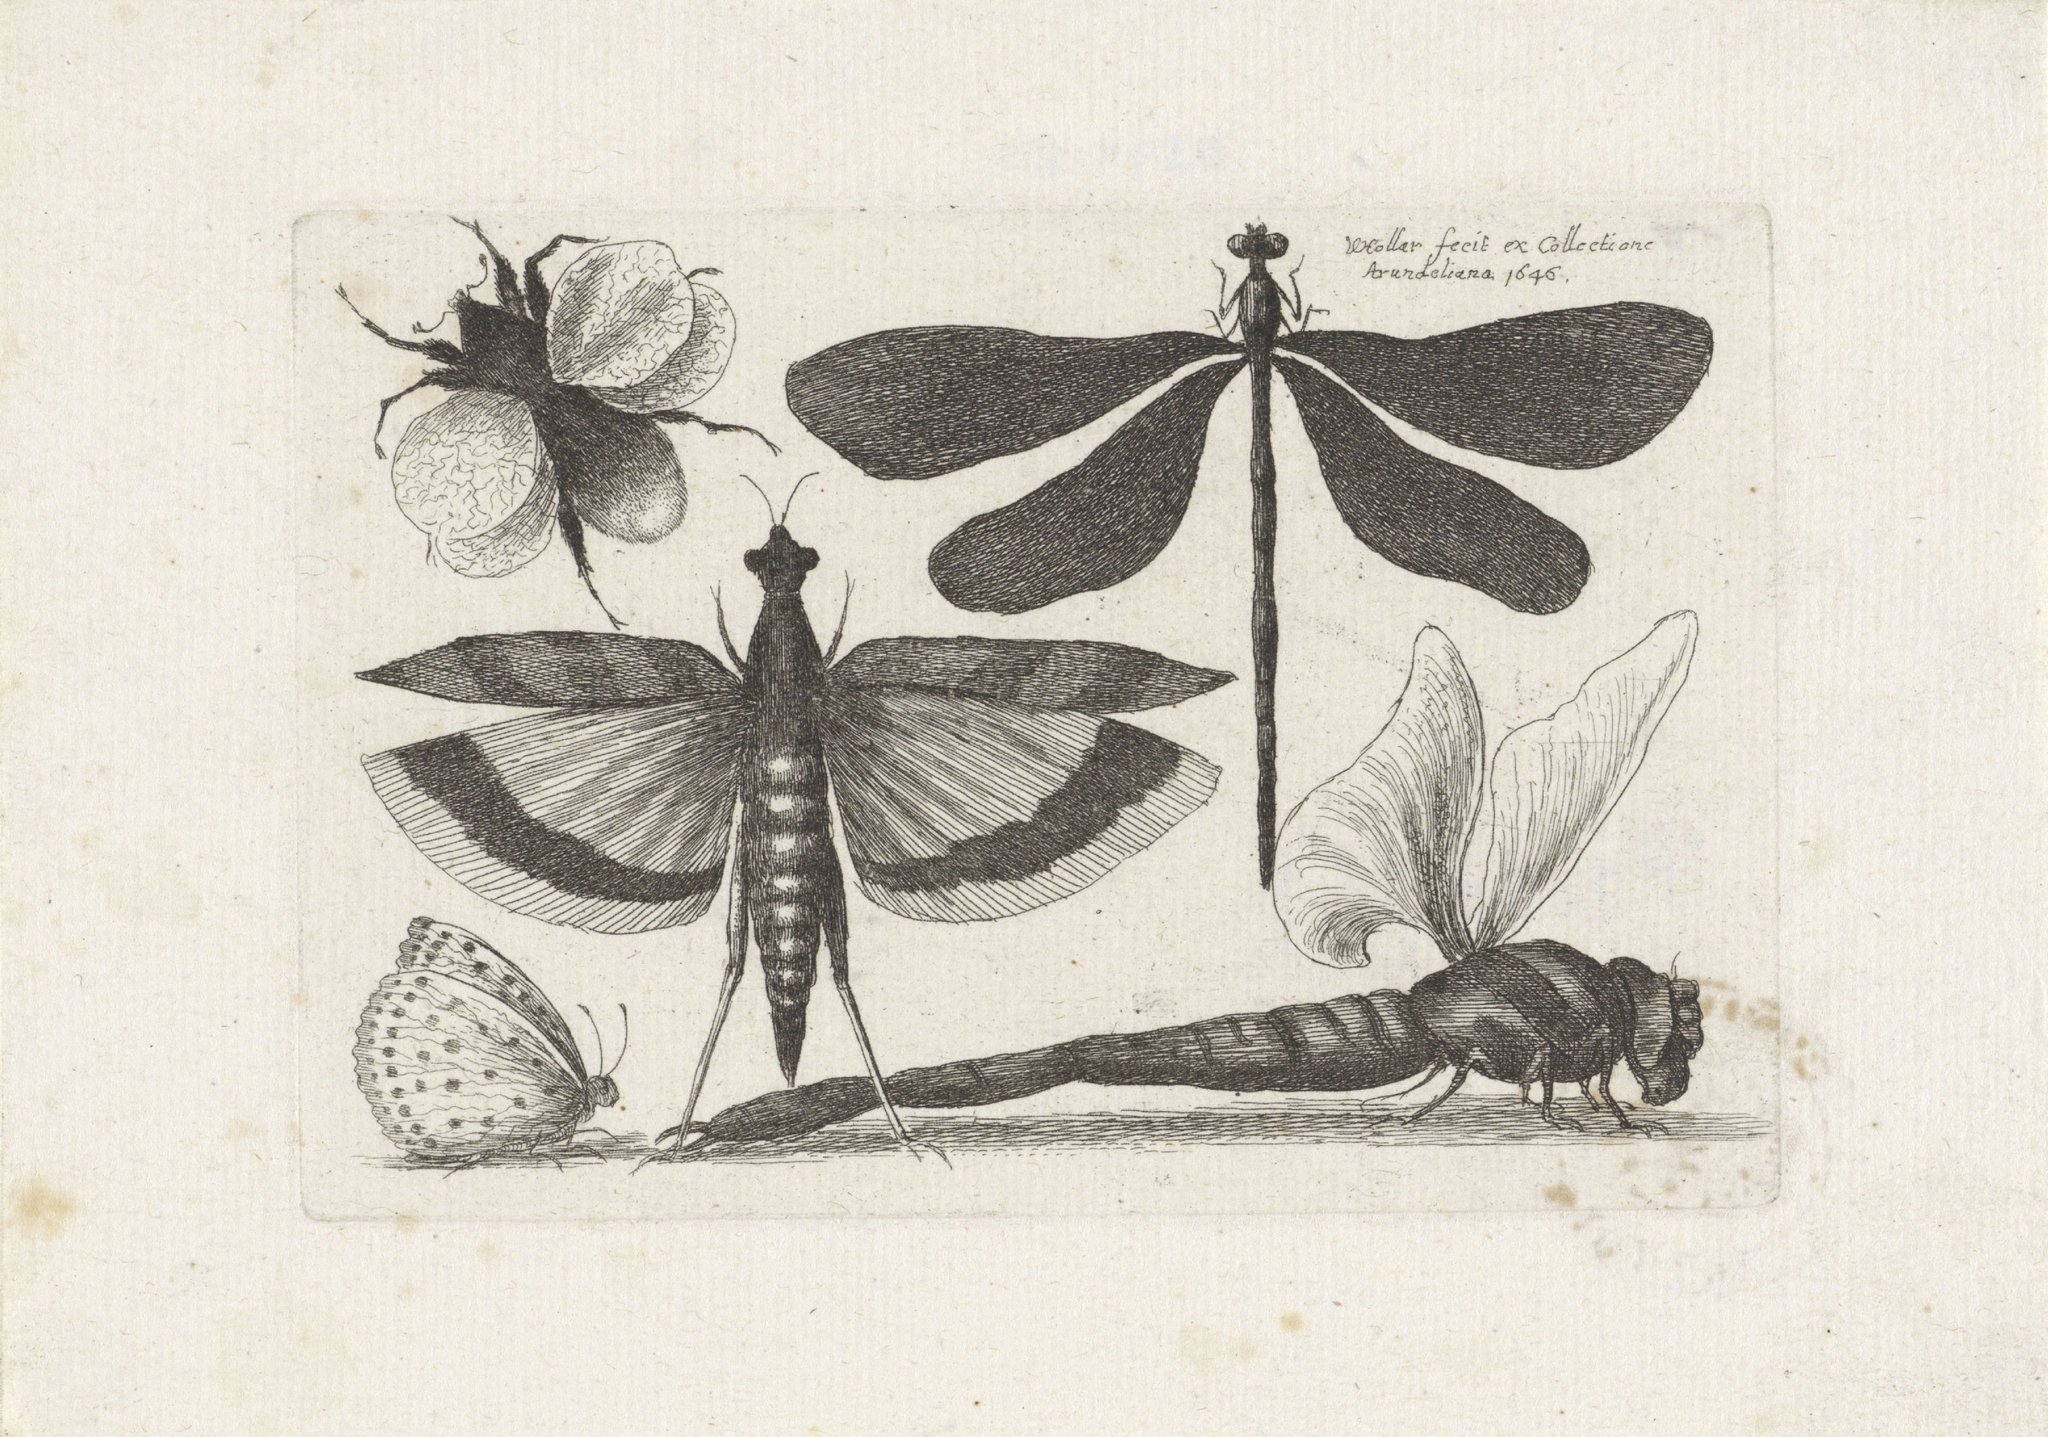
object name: print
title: Muscarum Scarabeorum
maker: wenceslaus hollar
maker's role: draughtsman, print maker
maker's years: 1607-1677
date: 1646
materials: paper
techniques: etching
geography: antwerp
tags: insects: dragon-fly, insects: butterfly, insects: bumblebee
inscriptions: collector's mark: Lugt 240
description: Prent maakt deel uit van de twaalfdelige serie (incl. titelprent) met verschillende insecten: "Muscarum Scarabeorum".